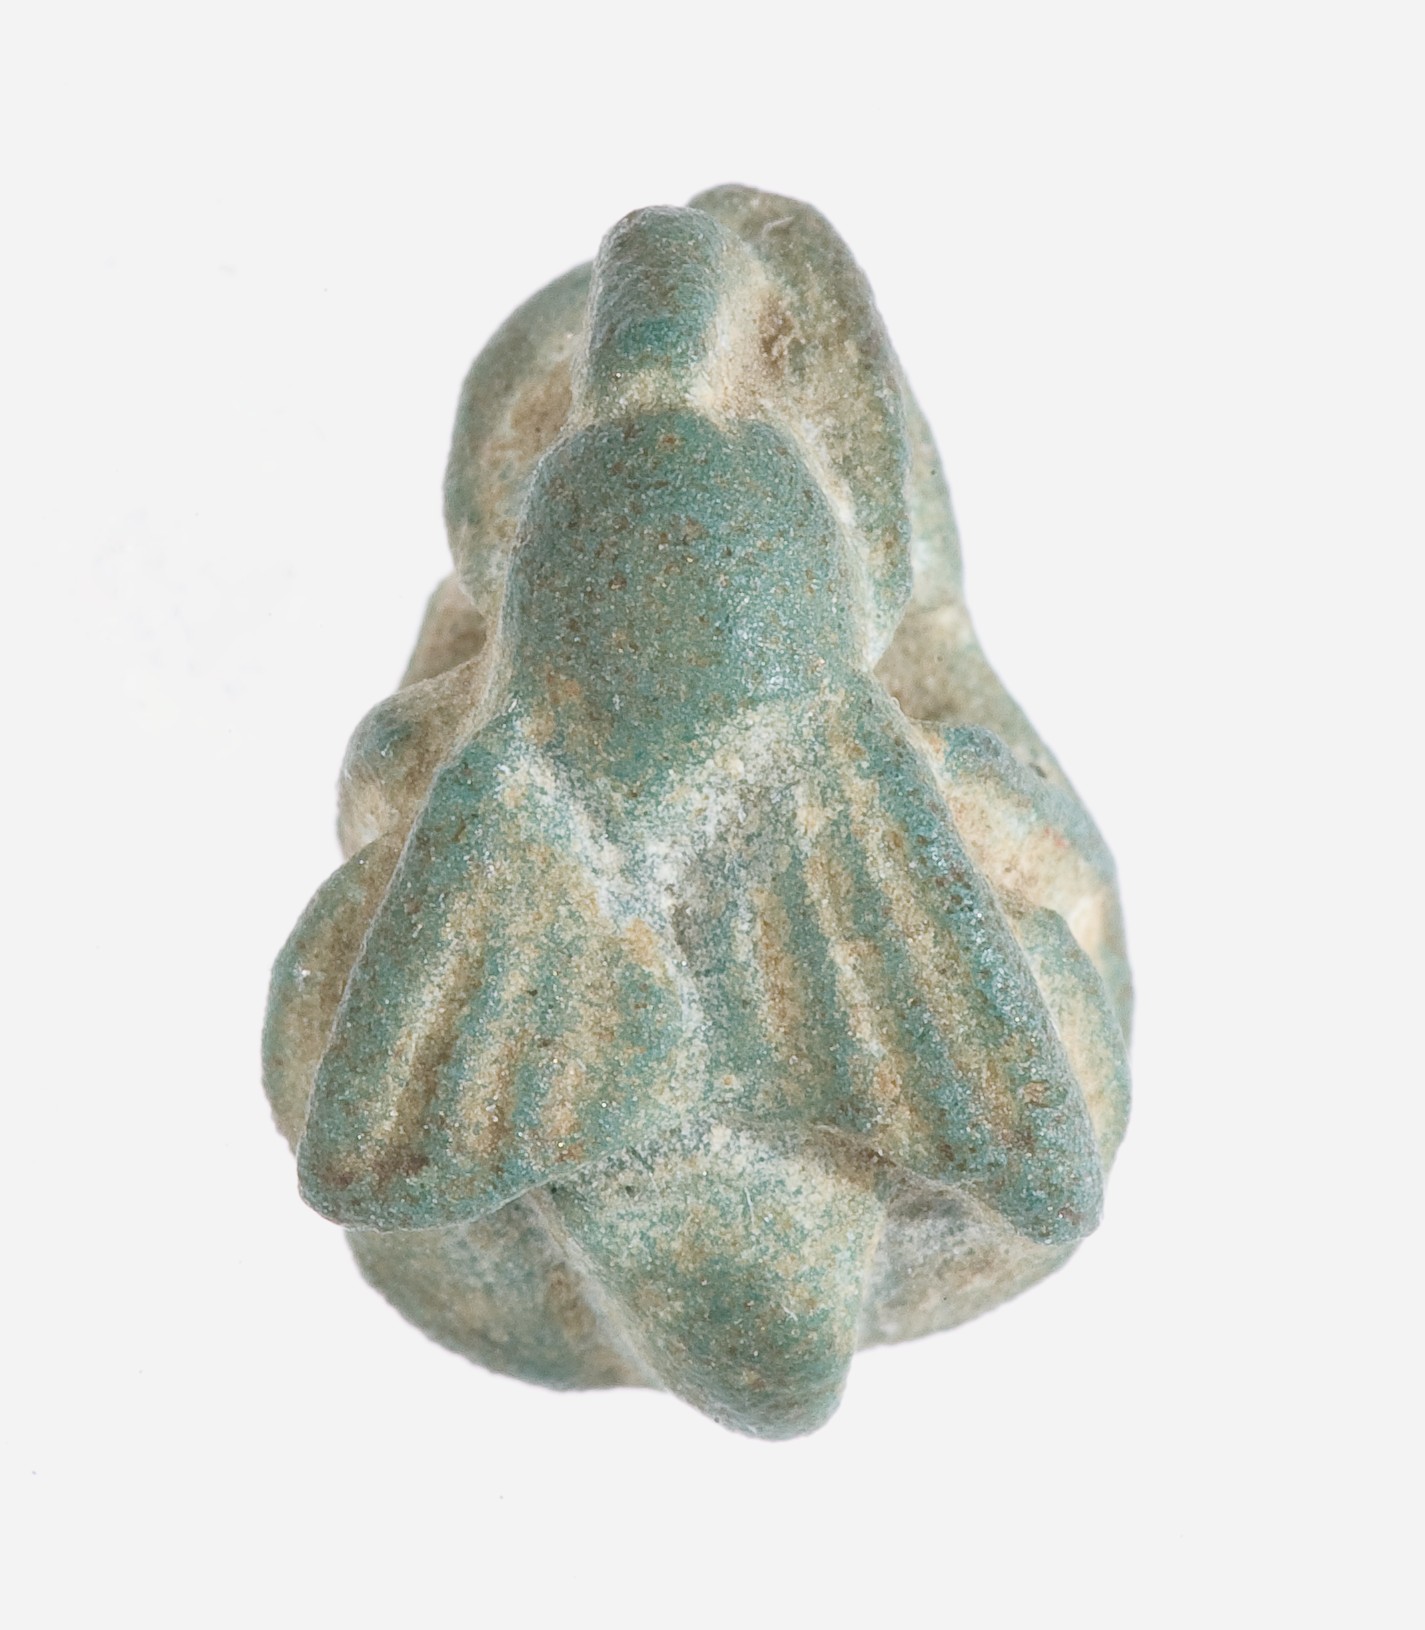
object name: amulet, fly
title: Fly amulet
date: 664-332 BCE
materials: faience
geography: egypt